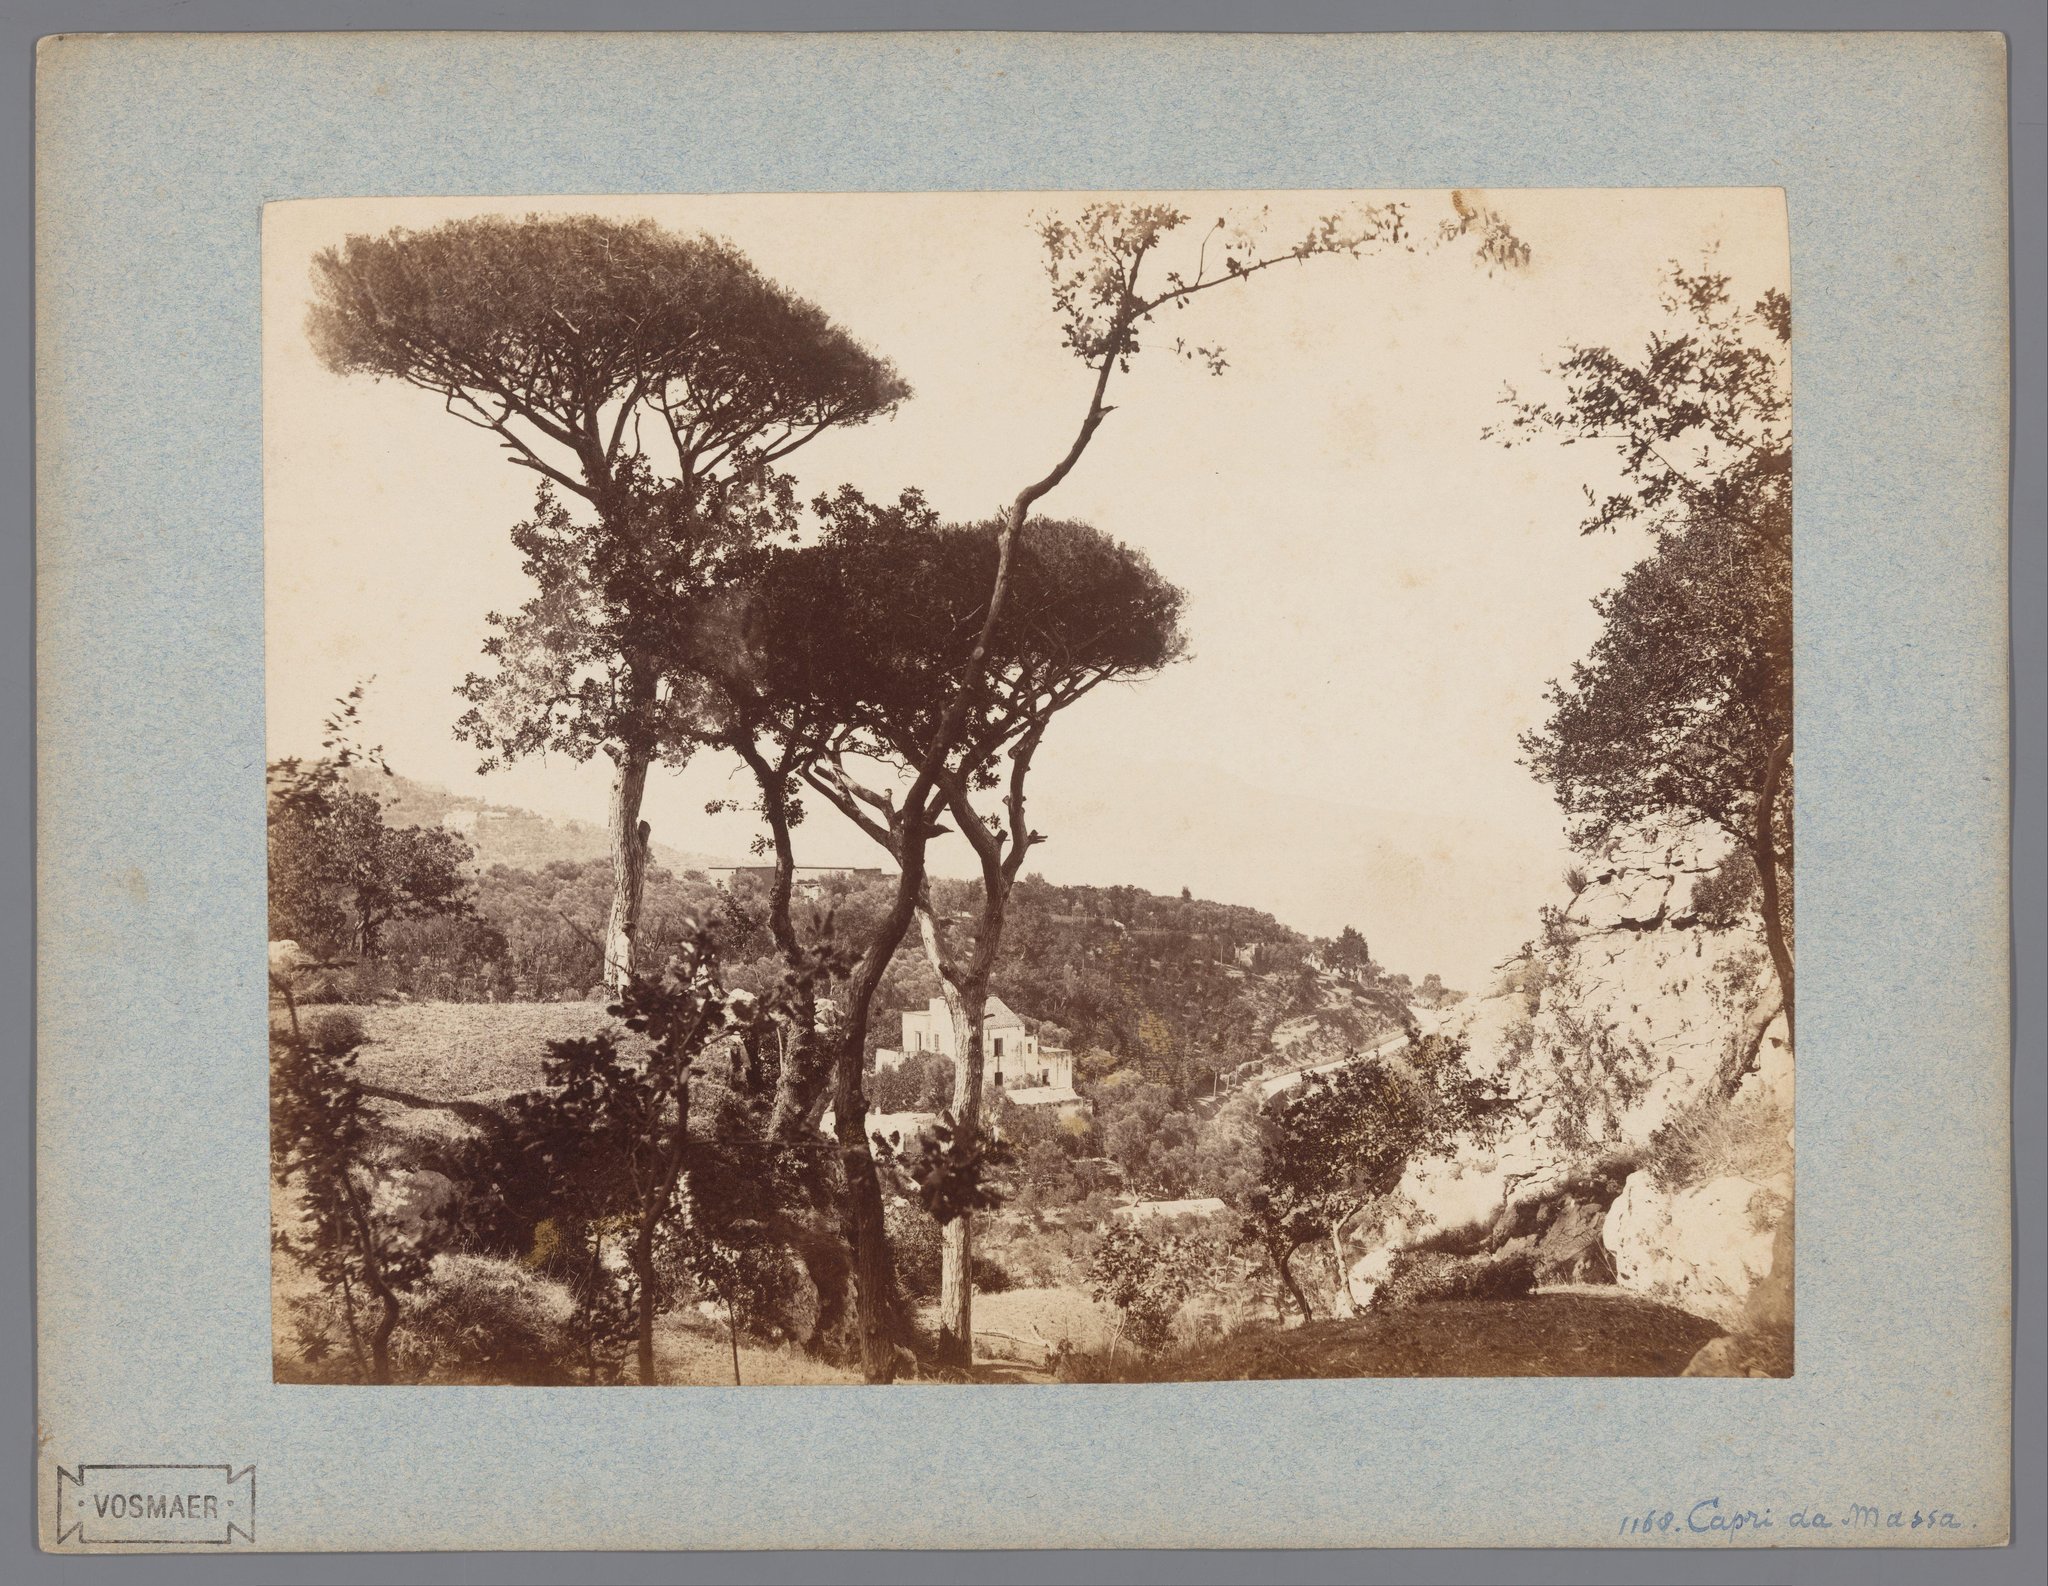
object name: photograph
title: Capri da Massa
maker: Anonymous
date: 1851-1900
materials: cardboard, paper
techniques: albumen print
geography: capri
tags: trees, landscapes in the temperate zone, capri, isola di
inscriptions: collector's mark: ‘VOSMAER’, number: ‘1168.’